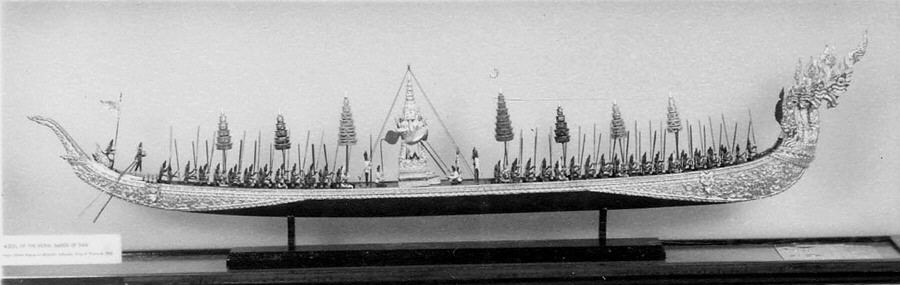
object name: barge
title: Replica of a Royal Barge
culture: thai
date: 1901-2000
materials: wood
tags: boats